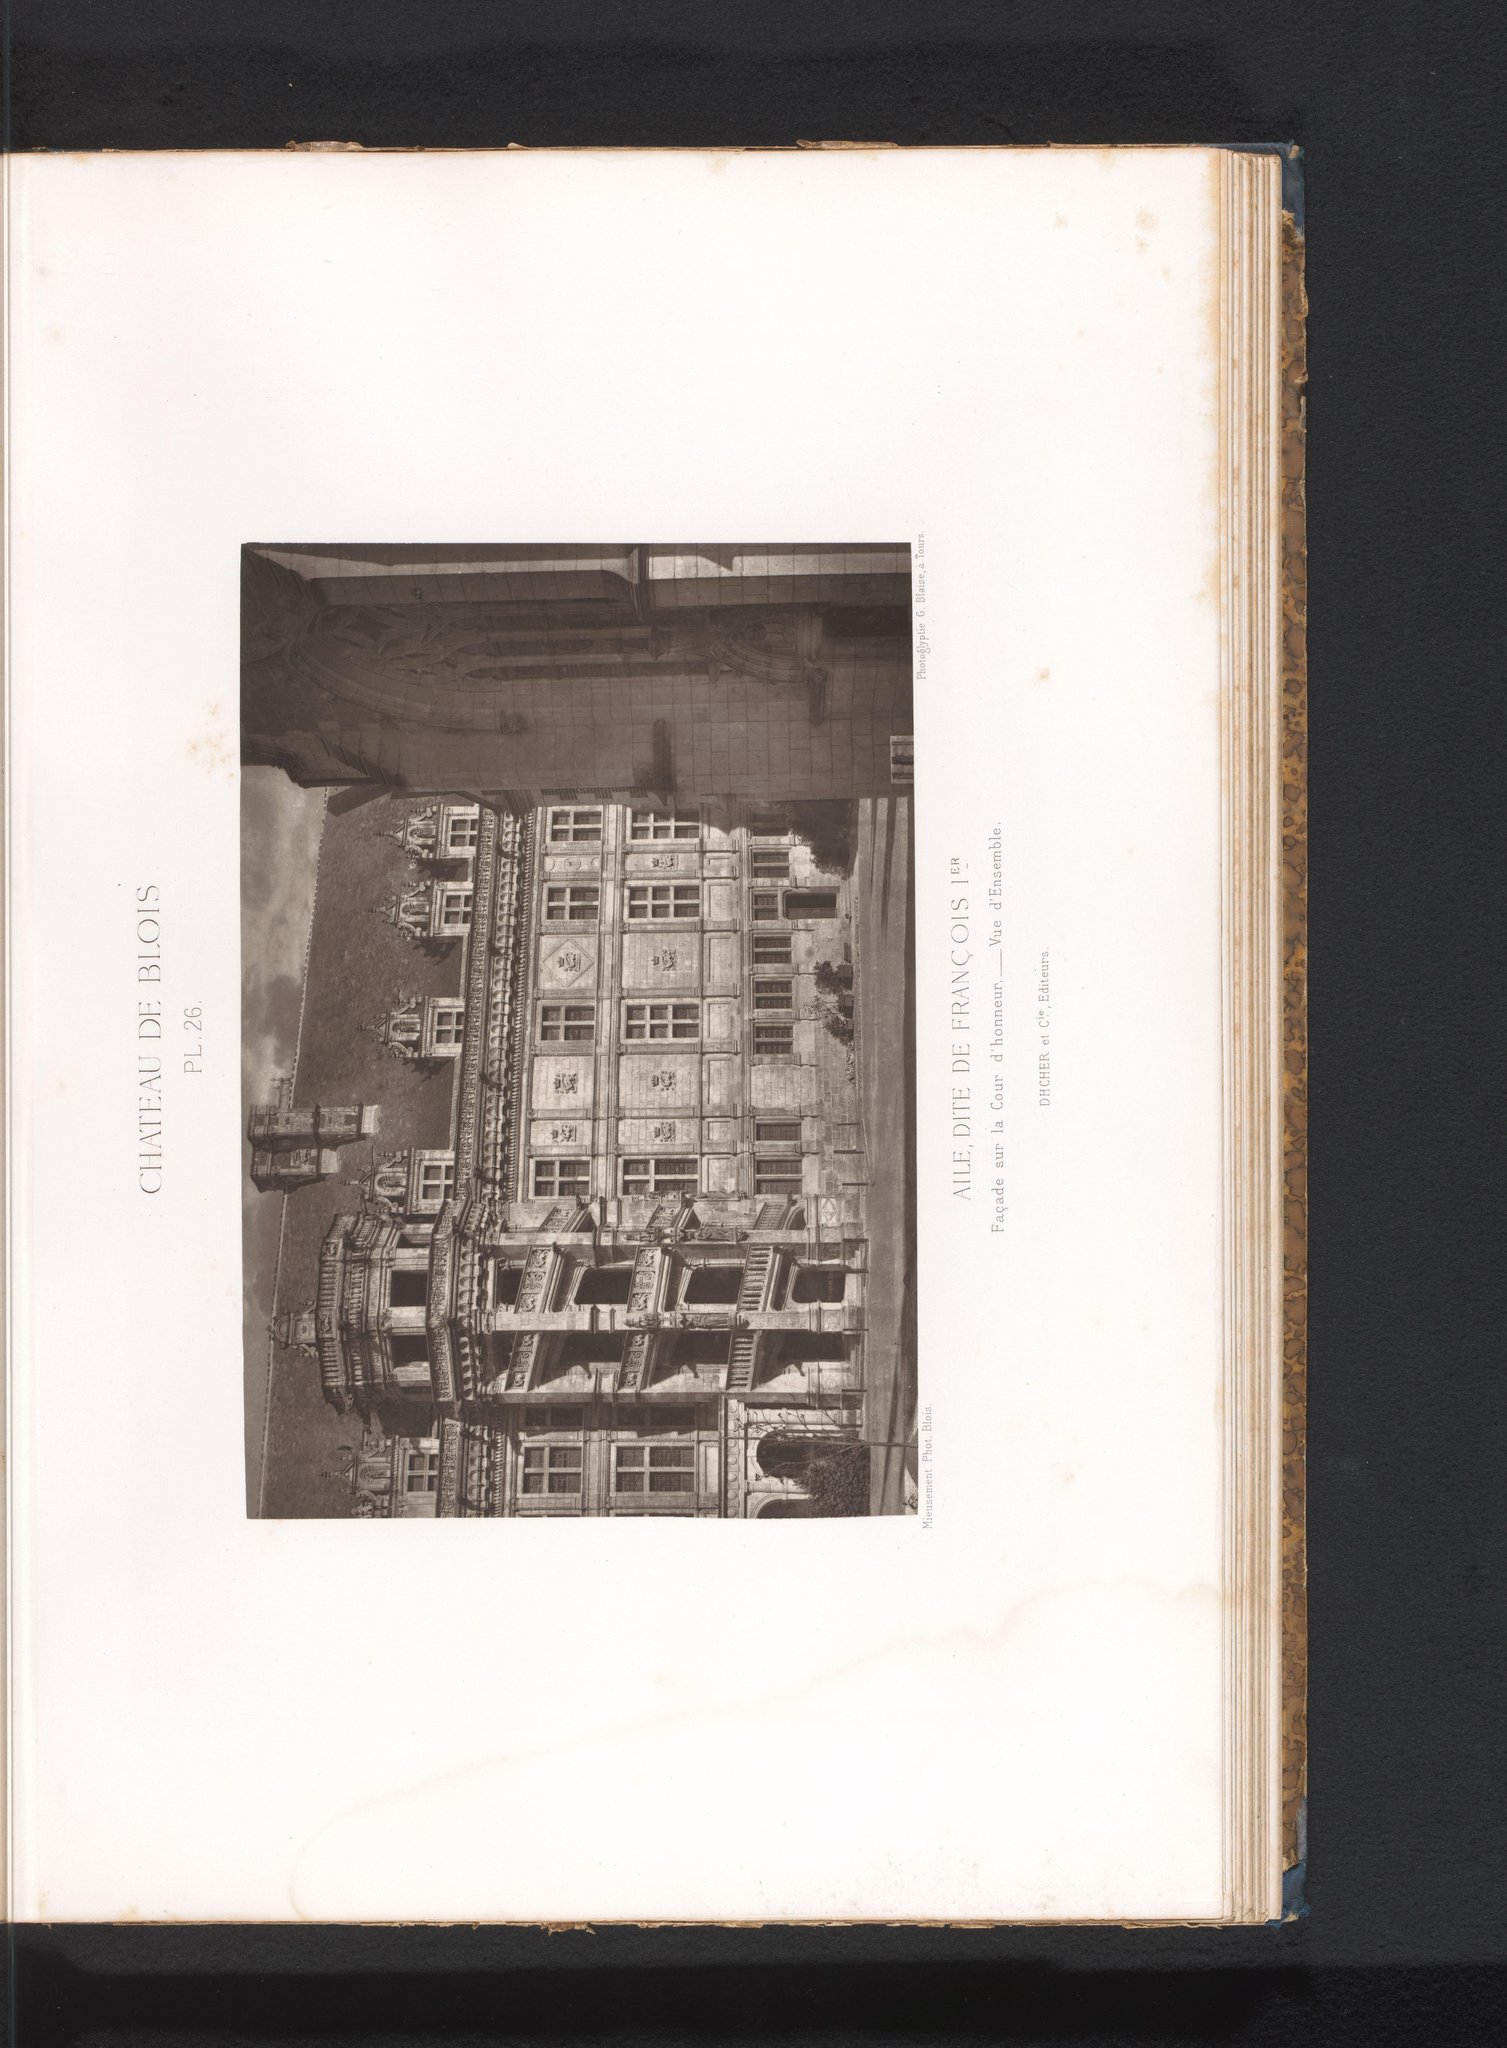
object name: page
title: Gezicht op de Frans I vleugel van het Kasteel van Blois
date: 1870-1875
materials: paper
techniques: woodburytype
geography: blois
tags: castle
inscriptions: number: ‘PL. 26.’